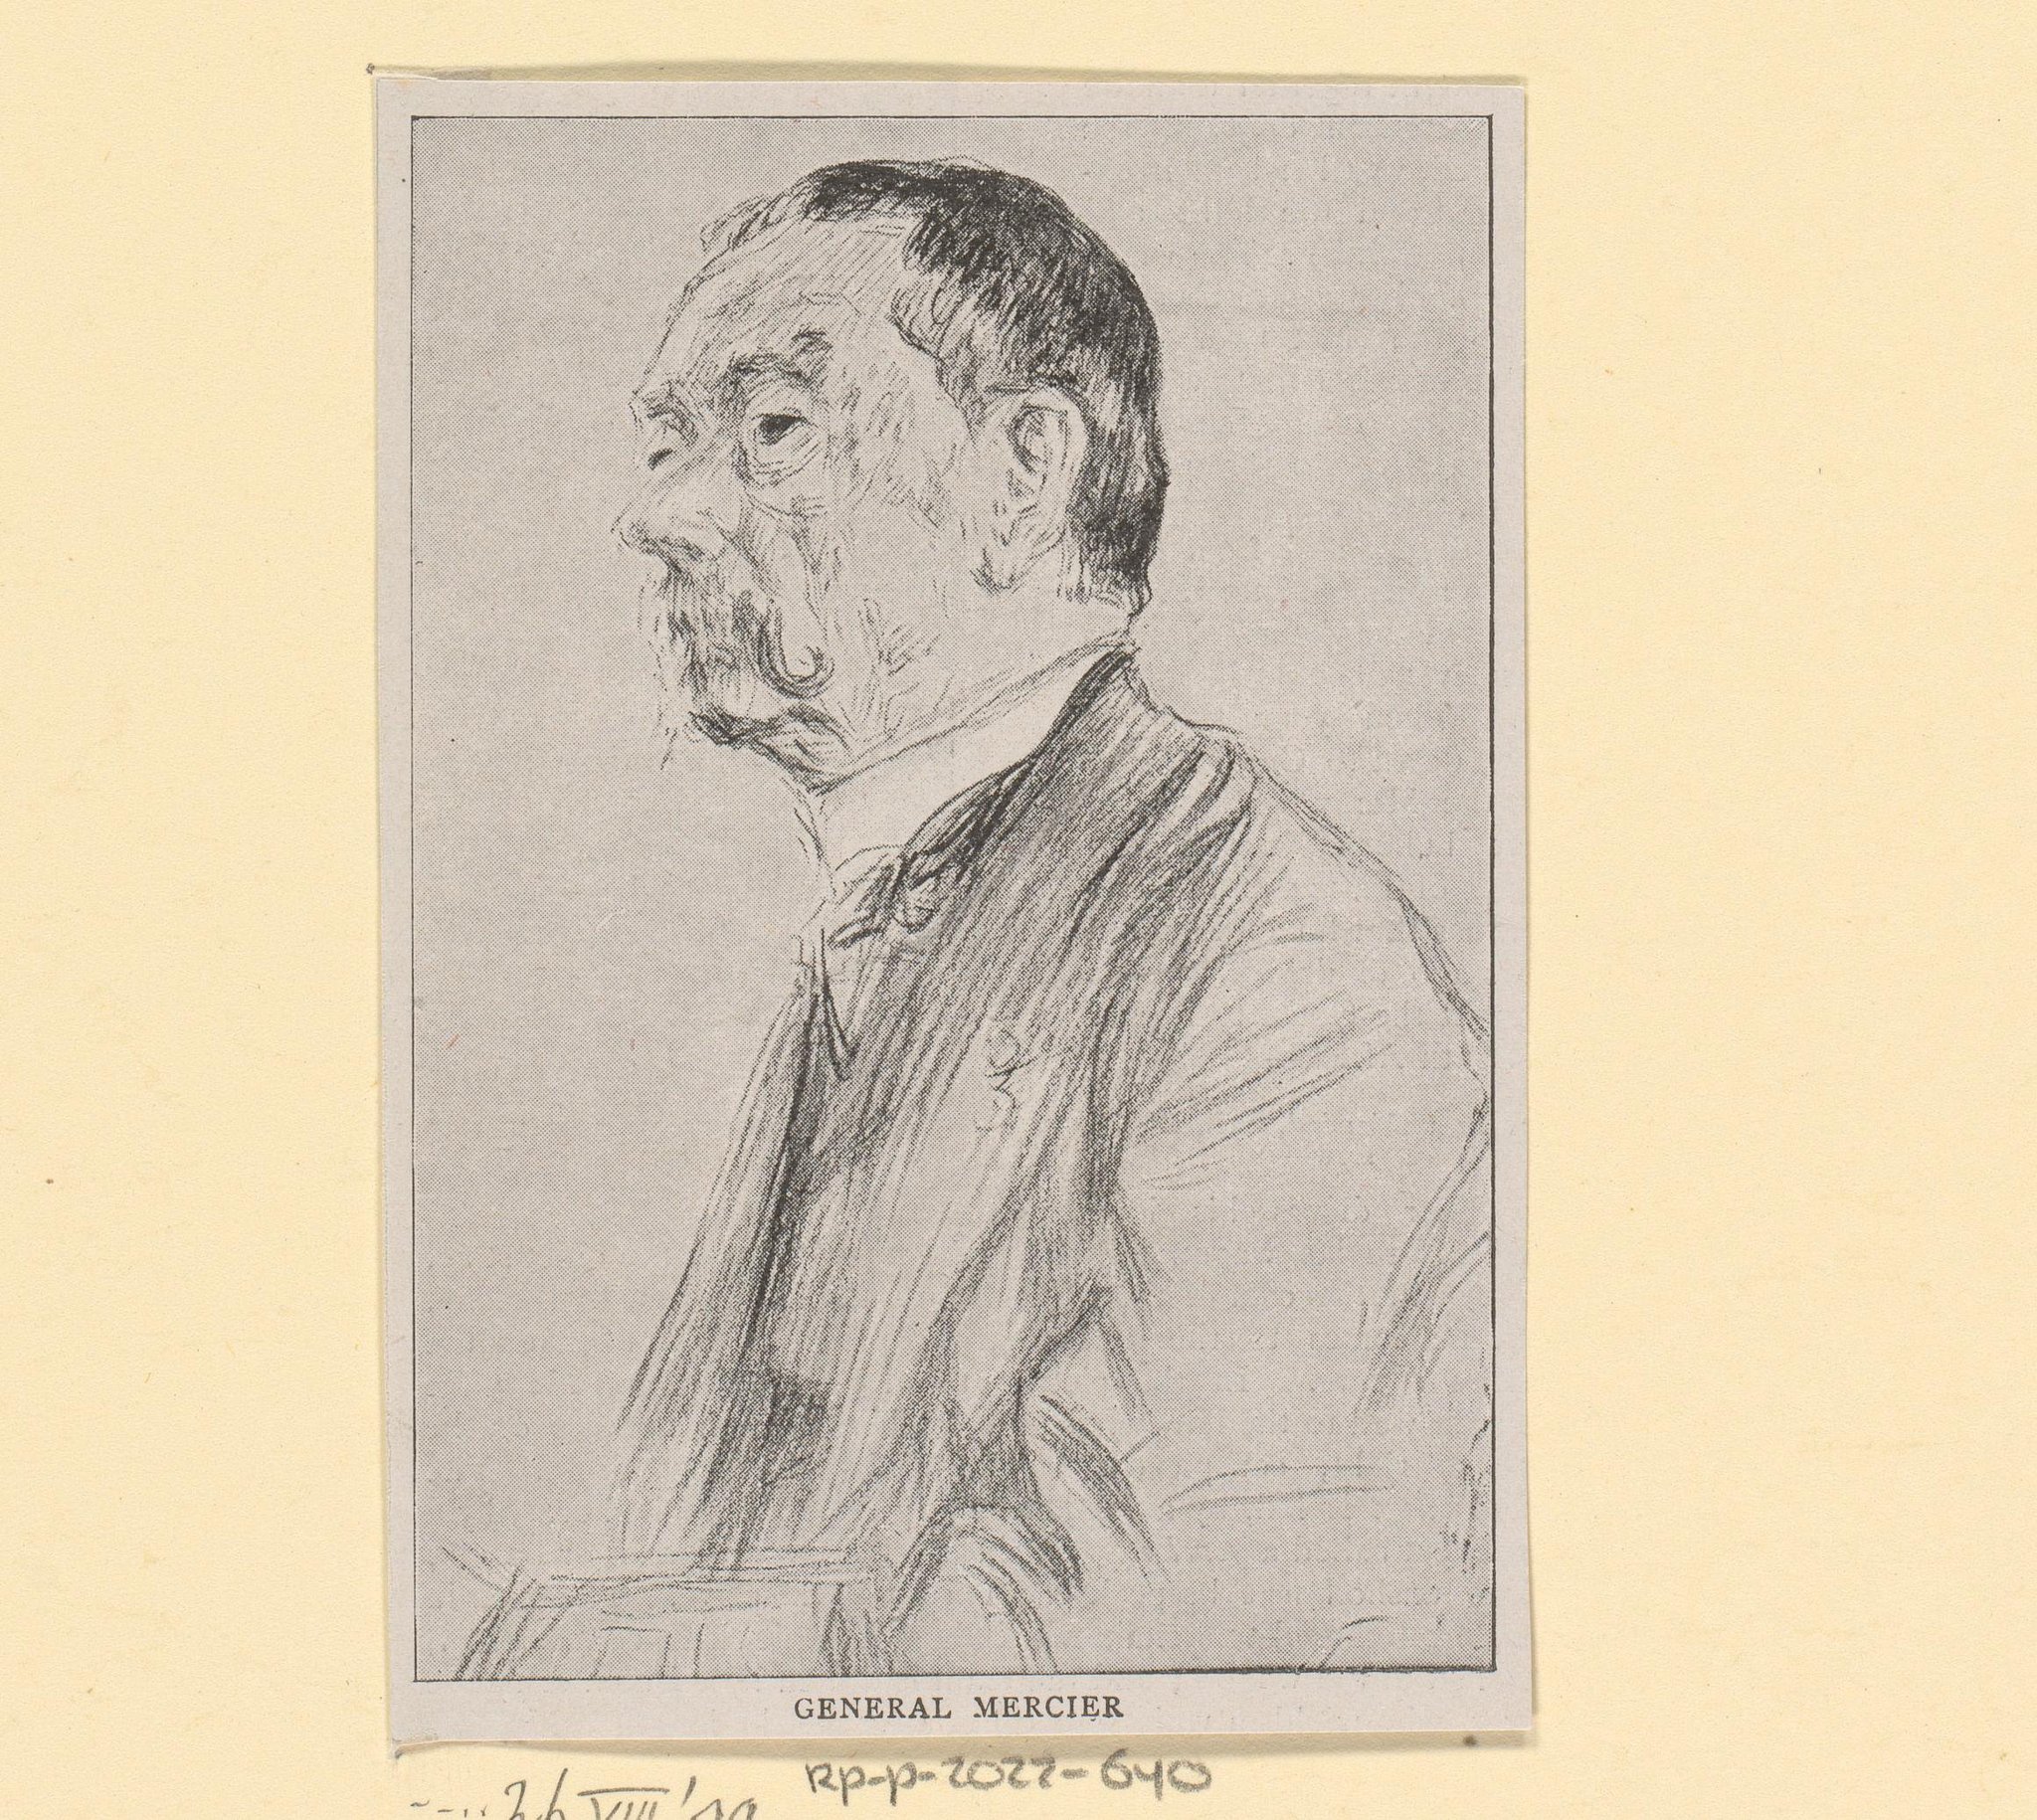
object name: photomechanical print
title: General Mercier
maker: Anonymous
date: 1999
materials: paper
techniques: letterpress printing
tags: historical persons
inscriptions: date: ‘26 Aug '99’